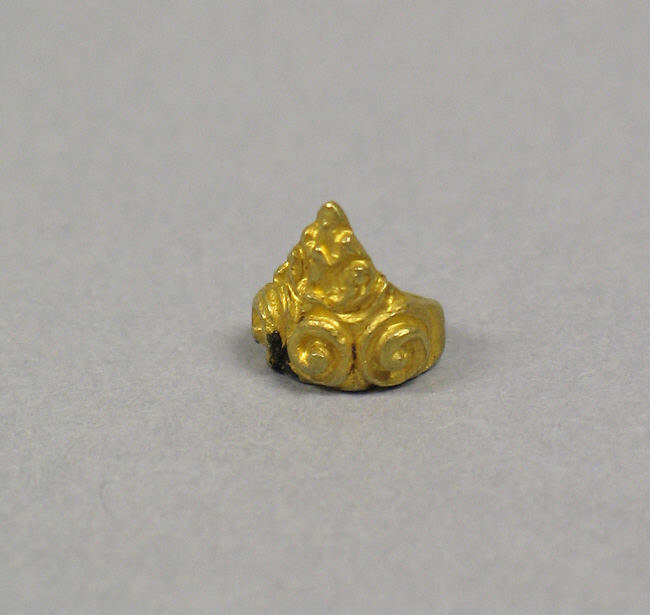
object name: ear ornament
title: Ear Ornament Garuda, Meru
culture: indonesian, central java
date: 701-1200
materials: gold